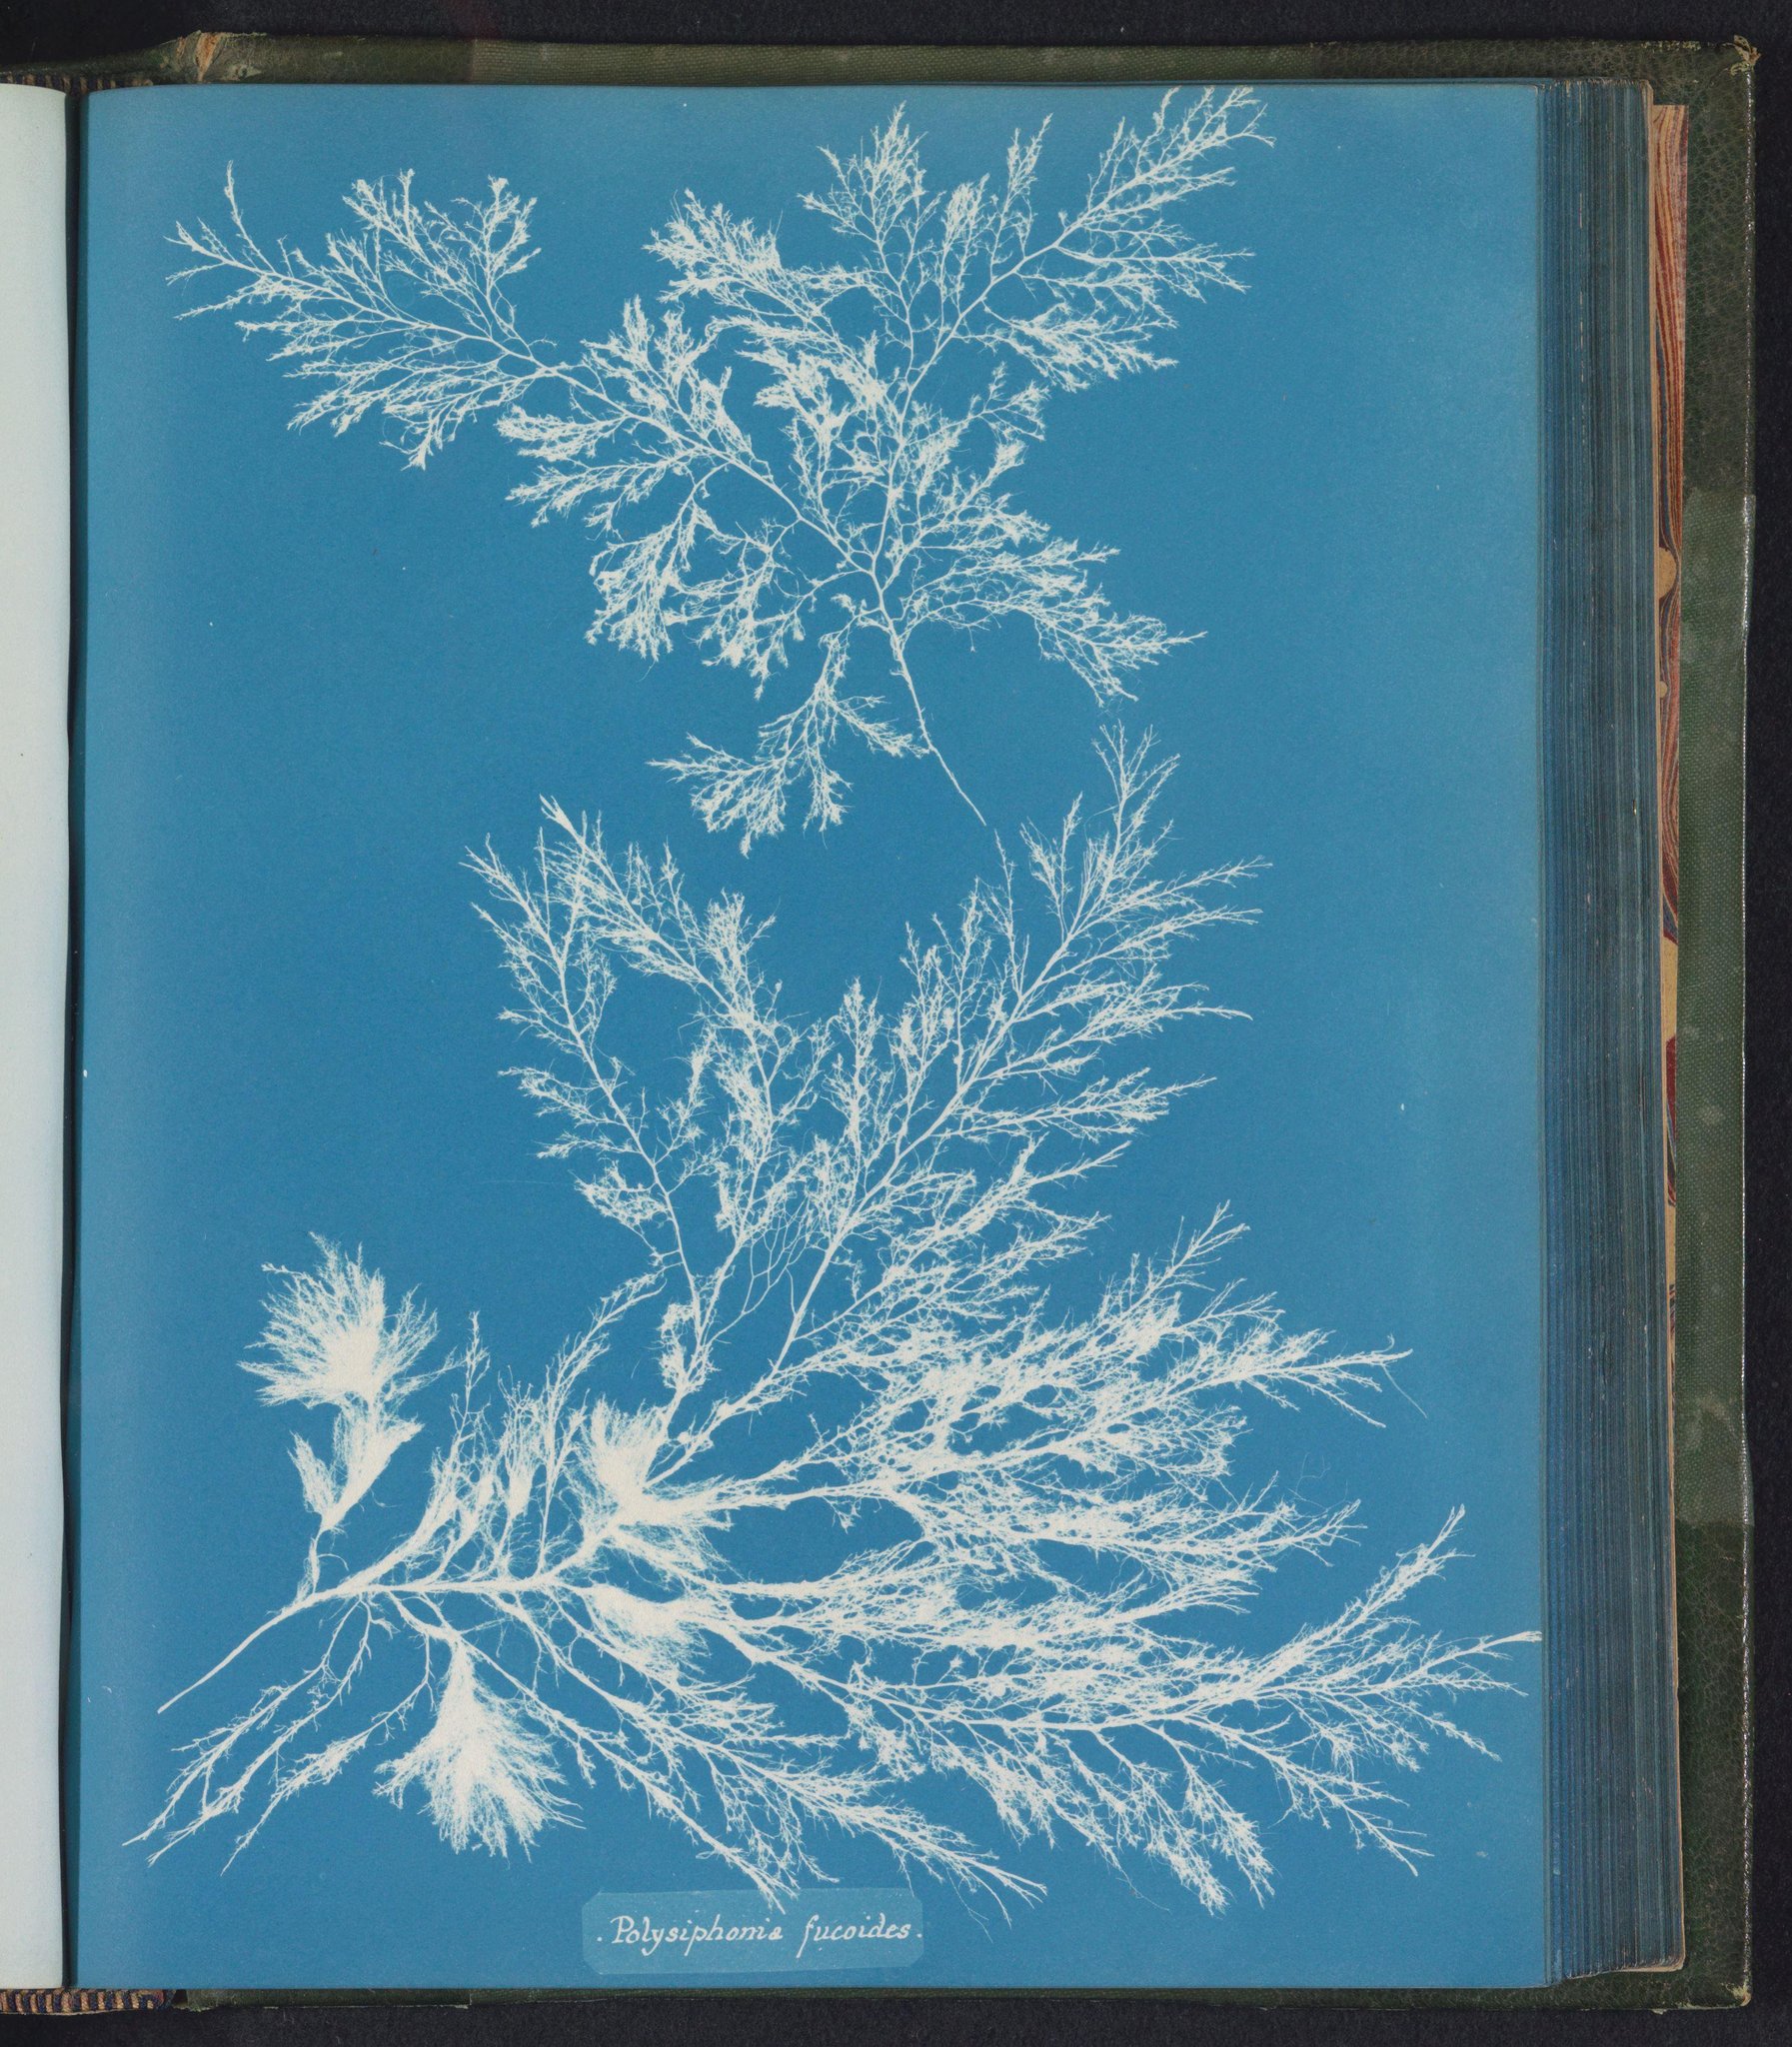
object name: page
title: Polysiphonia fucoides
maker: anna atkins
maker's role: fotograaf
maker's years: 1799-1871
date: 1843-1853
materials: photographic support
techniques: cyanotype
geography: united kingdom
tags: algae, seaweed